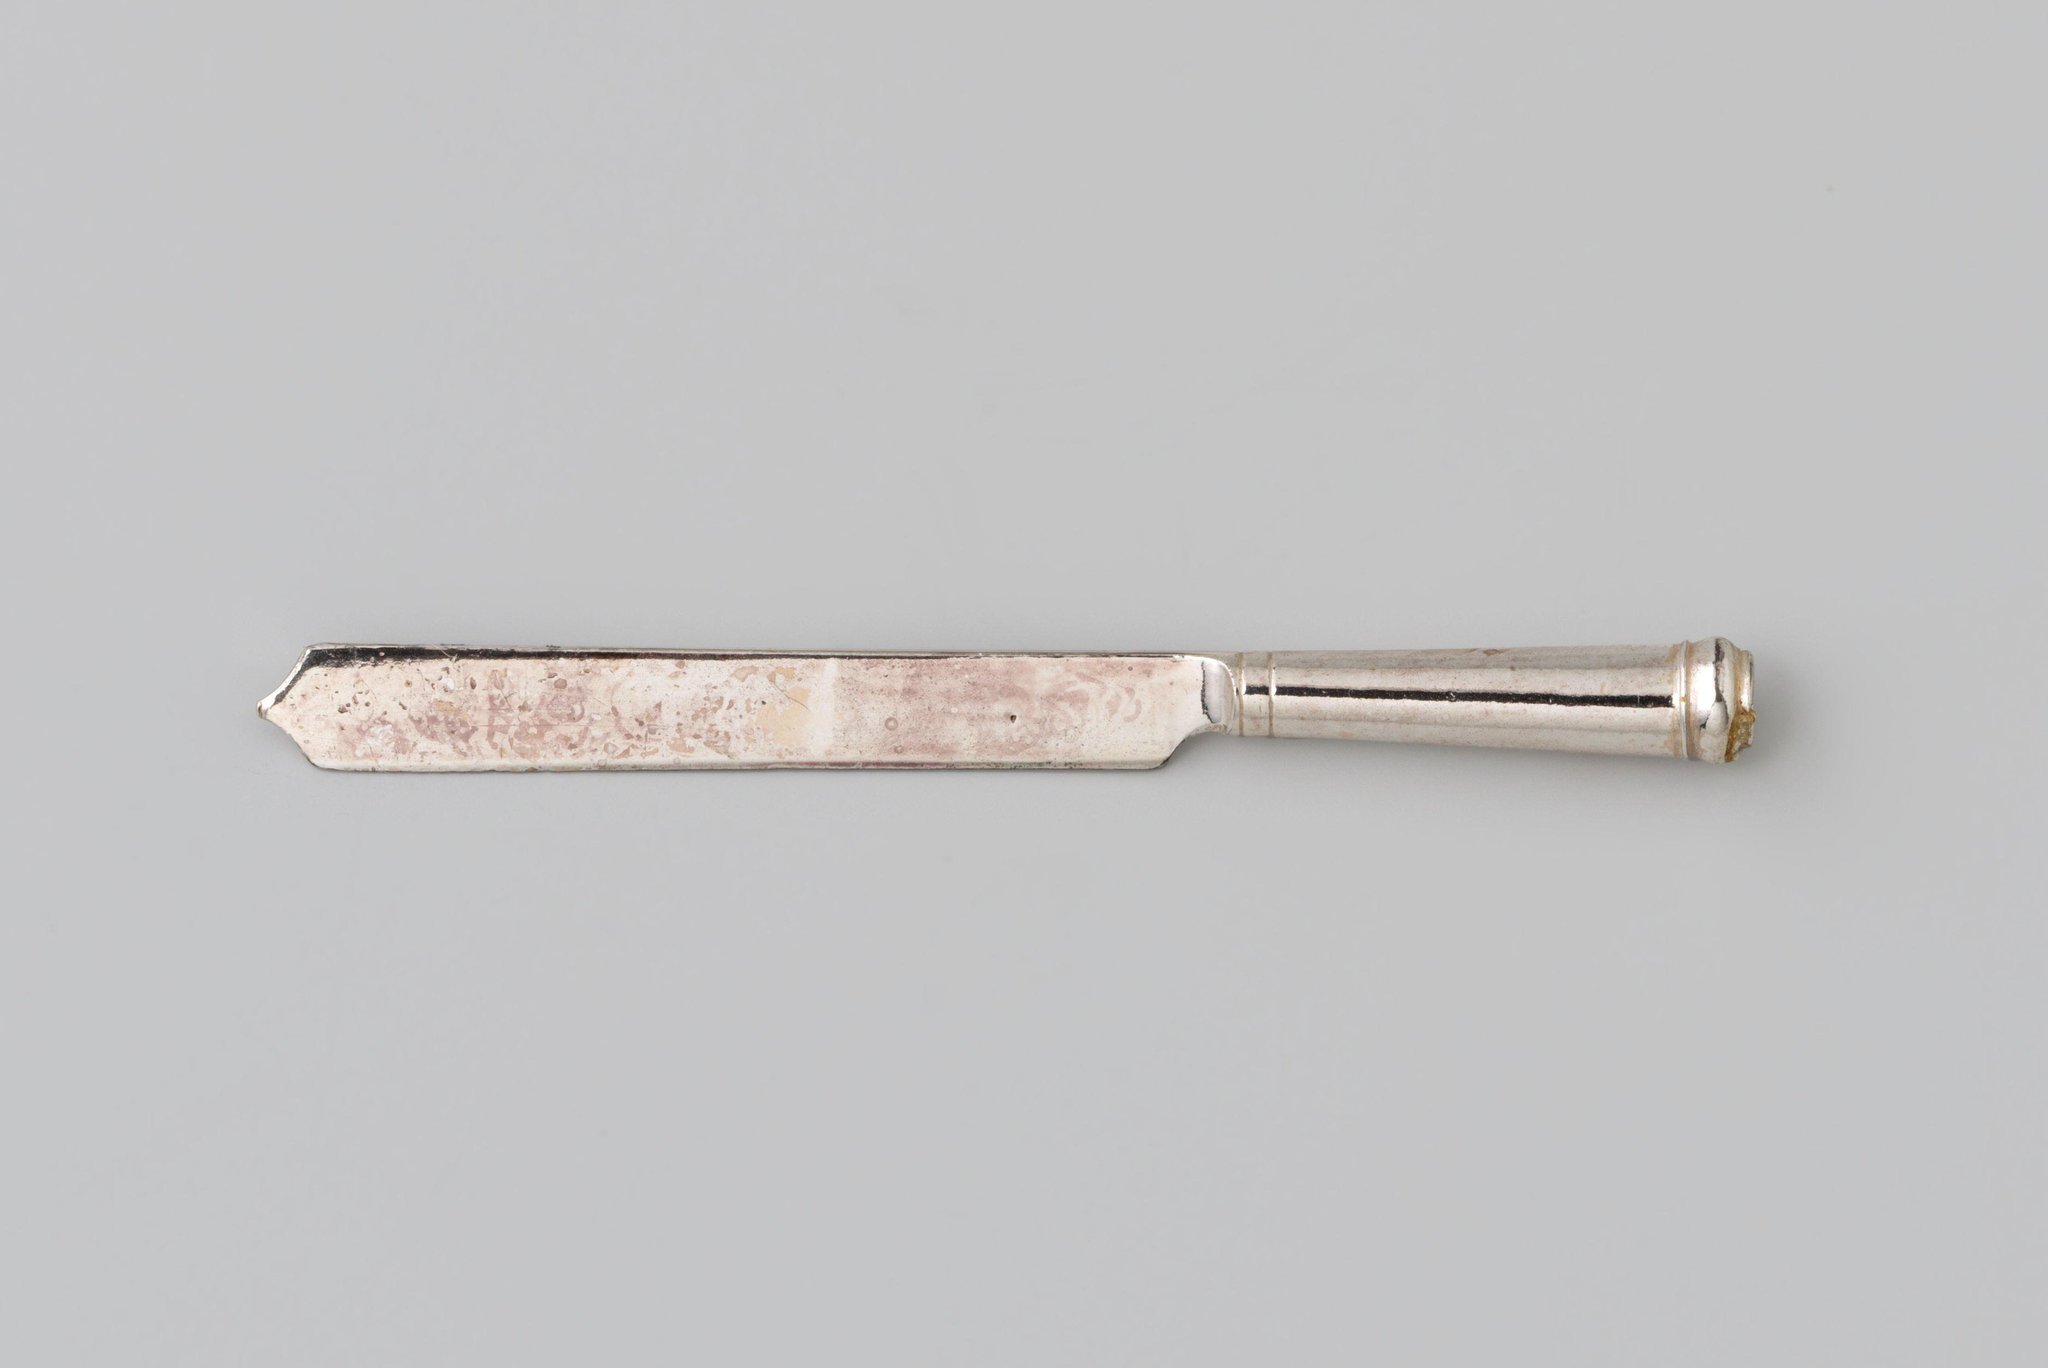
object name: miniature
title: Mes van zilver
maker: Anonymous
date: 1800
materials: silver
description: Mes van zilver met recht, rond heft en recht lemmet eindigend in een driehoekige punt.